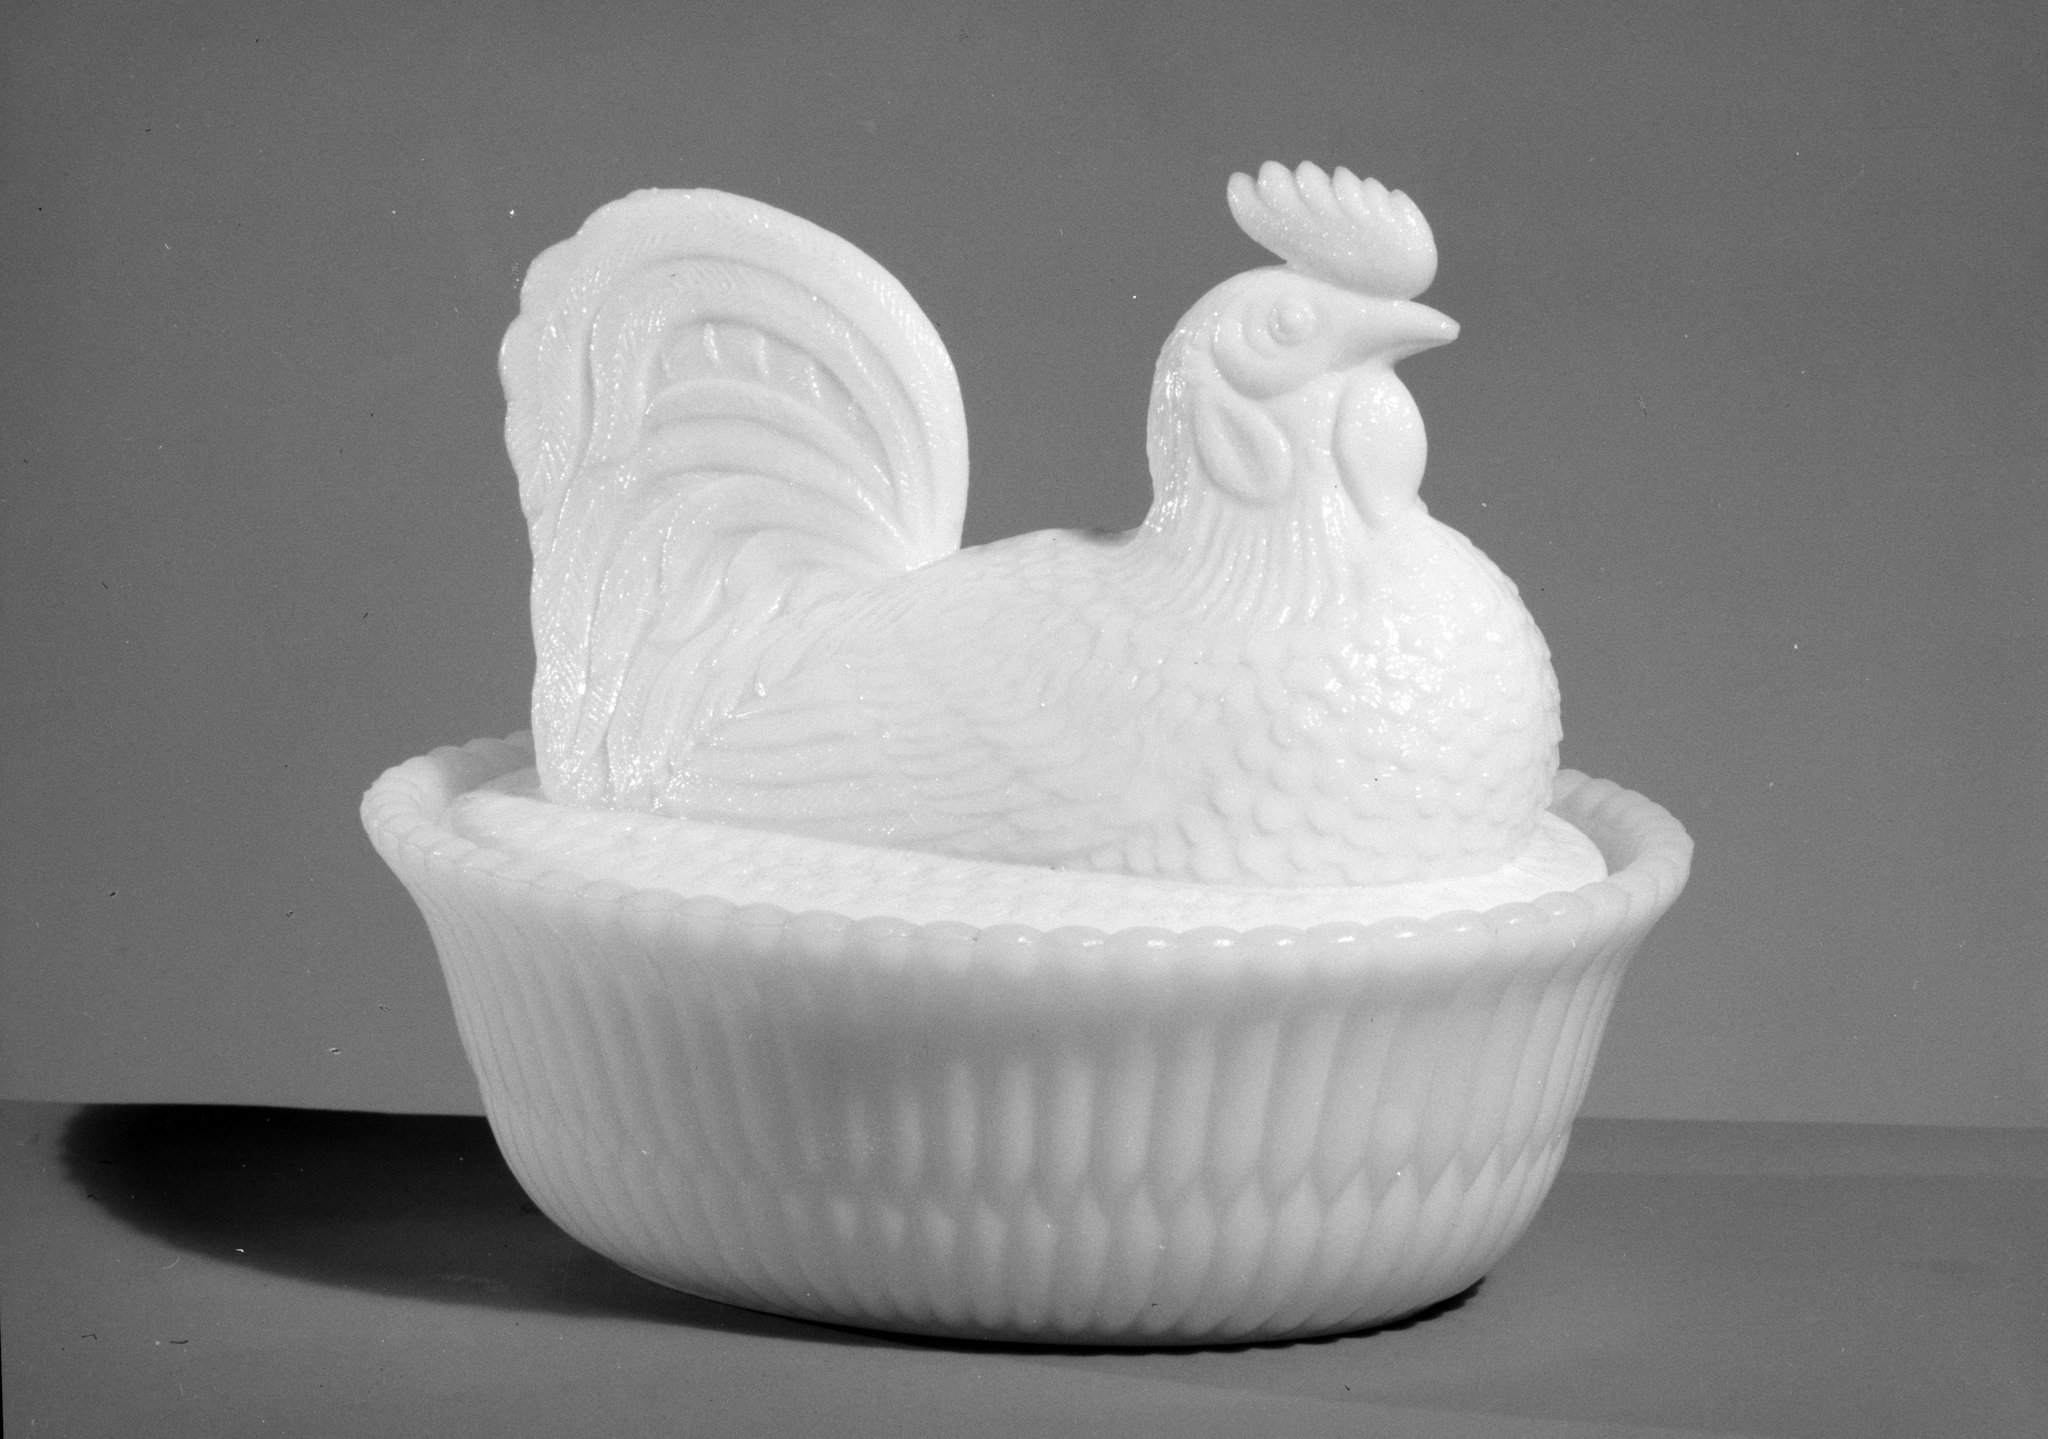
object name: dish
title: Figure Dish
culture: american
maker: mckee and brothers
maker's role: maker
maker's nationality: american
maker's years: 1856-1889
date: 1880-1890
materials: glass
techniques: pressed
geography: united states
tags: roosters